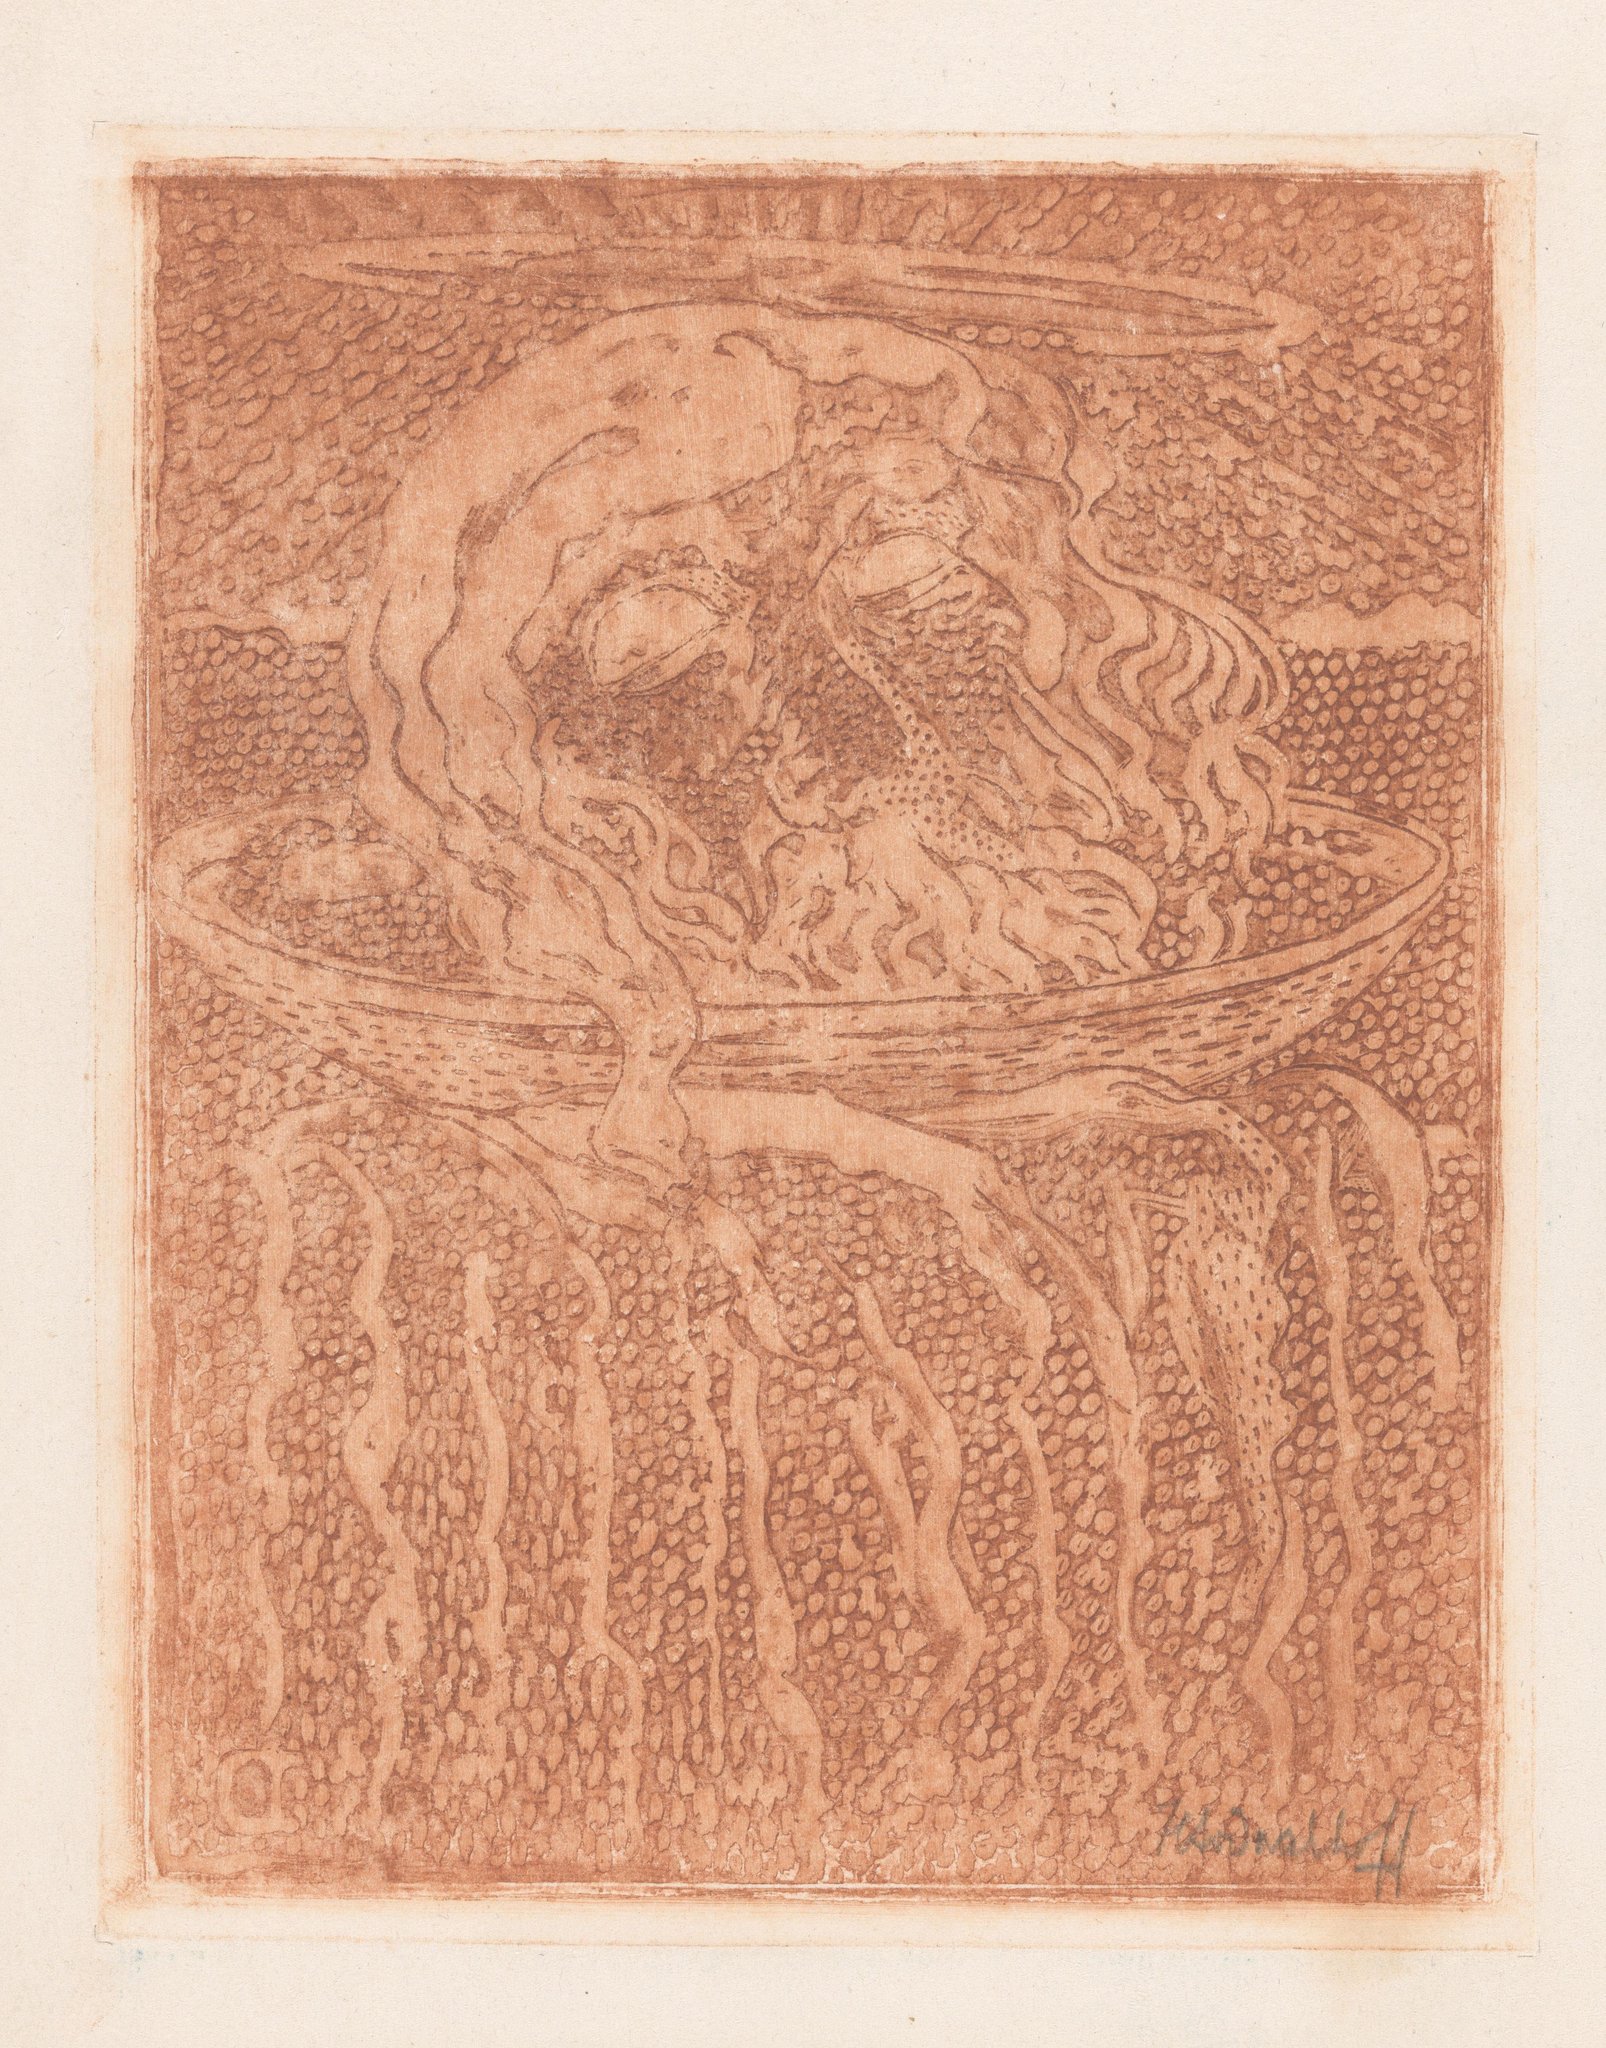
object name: print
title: Hoofd van Johannes de Doper op een schotel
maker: herman antonius van daalhoff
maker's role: draughtsman, print maker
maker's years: 1867-1953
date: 1915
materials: paper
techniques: etching, intaglio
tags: martyrdom and death of john the baptist (matthew 14:3-12; mark 6:17-29), head of a beheaded person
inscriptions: collector's mark: Lugt 2228, collector's mark: Lugt 2760